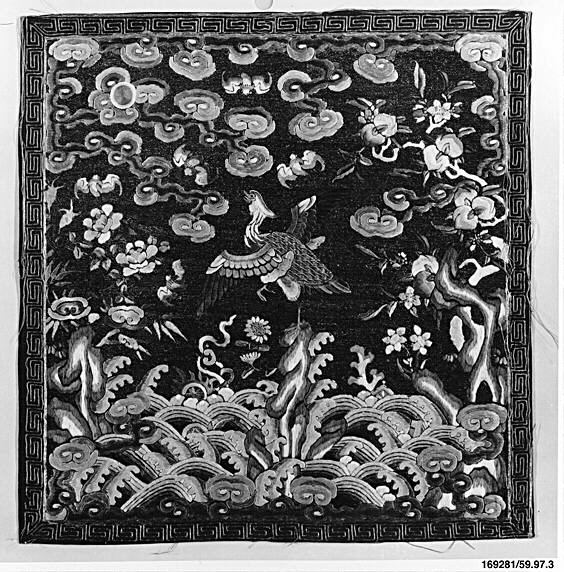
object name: rank badge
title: Rank Badge with Mandarin Duck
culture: chinese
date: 1701-1800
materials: silk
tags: bats,ducks